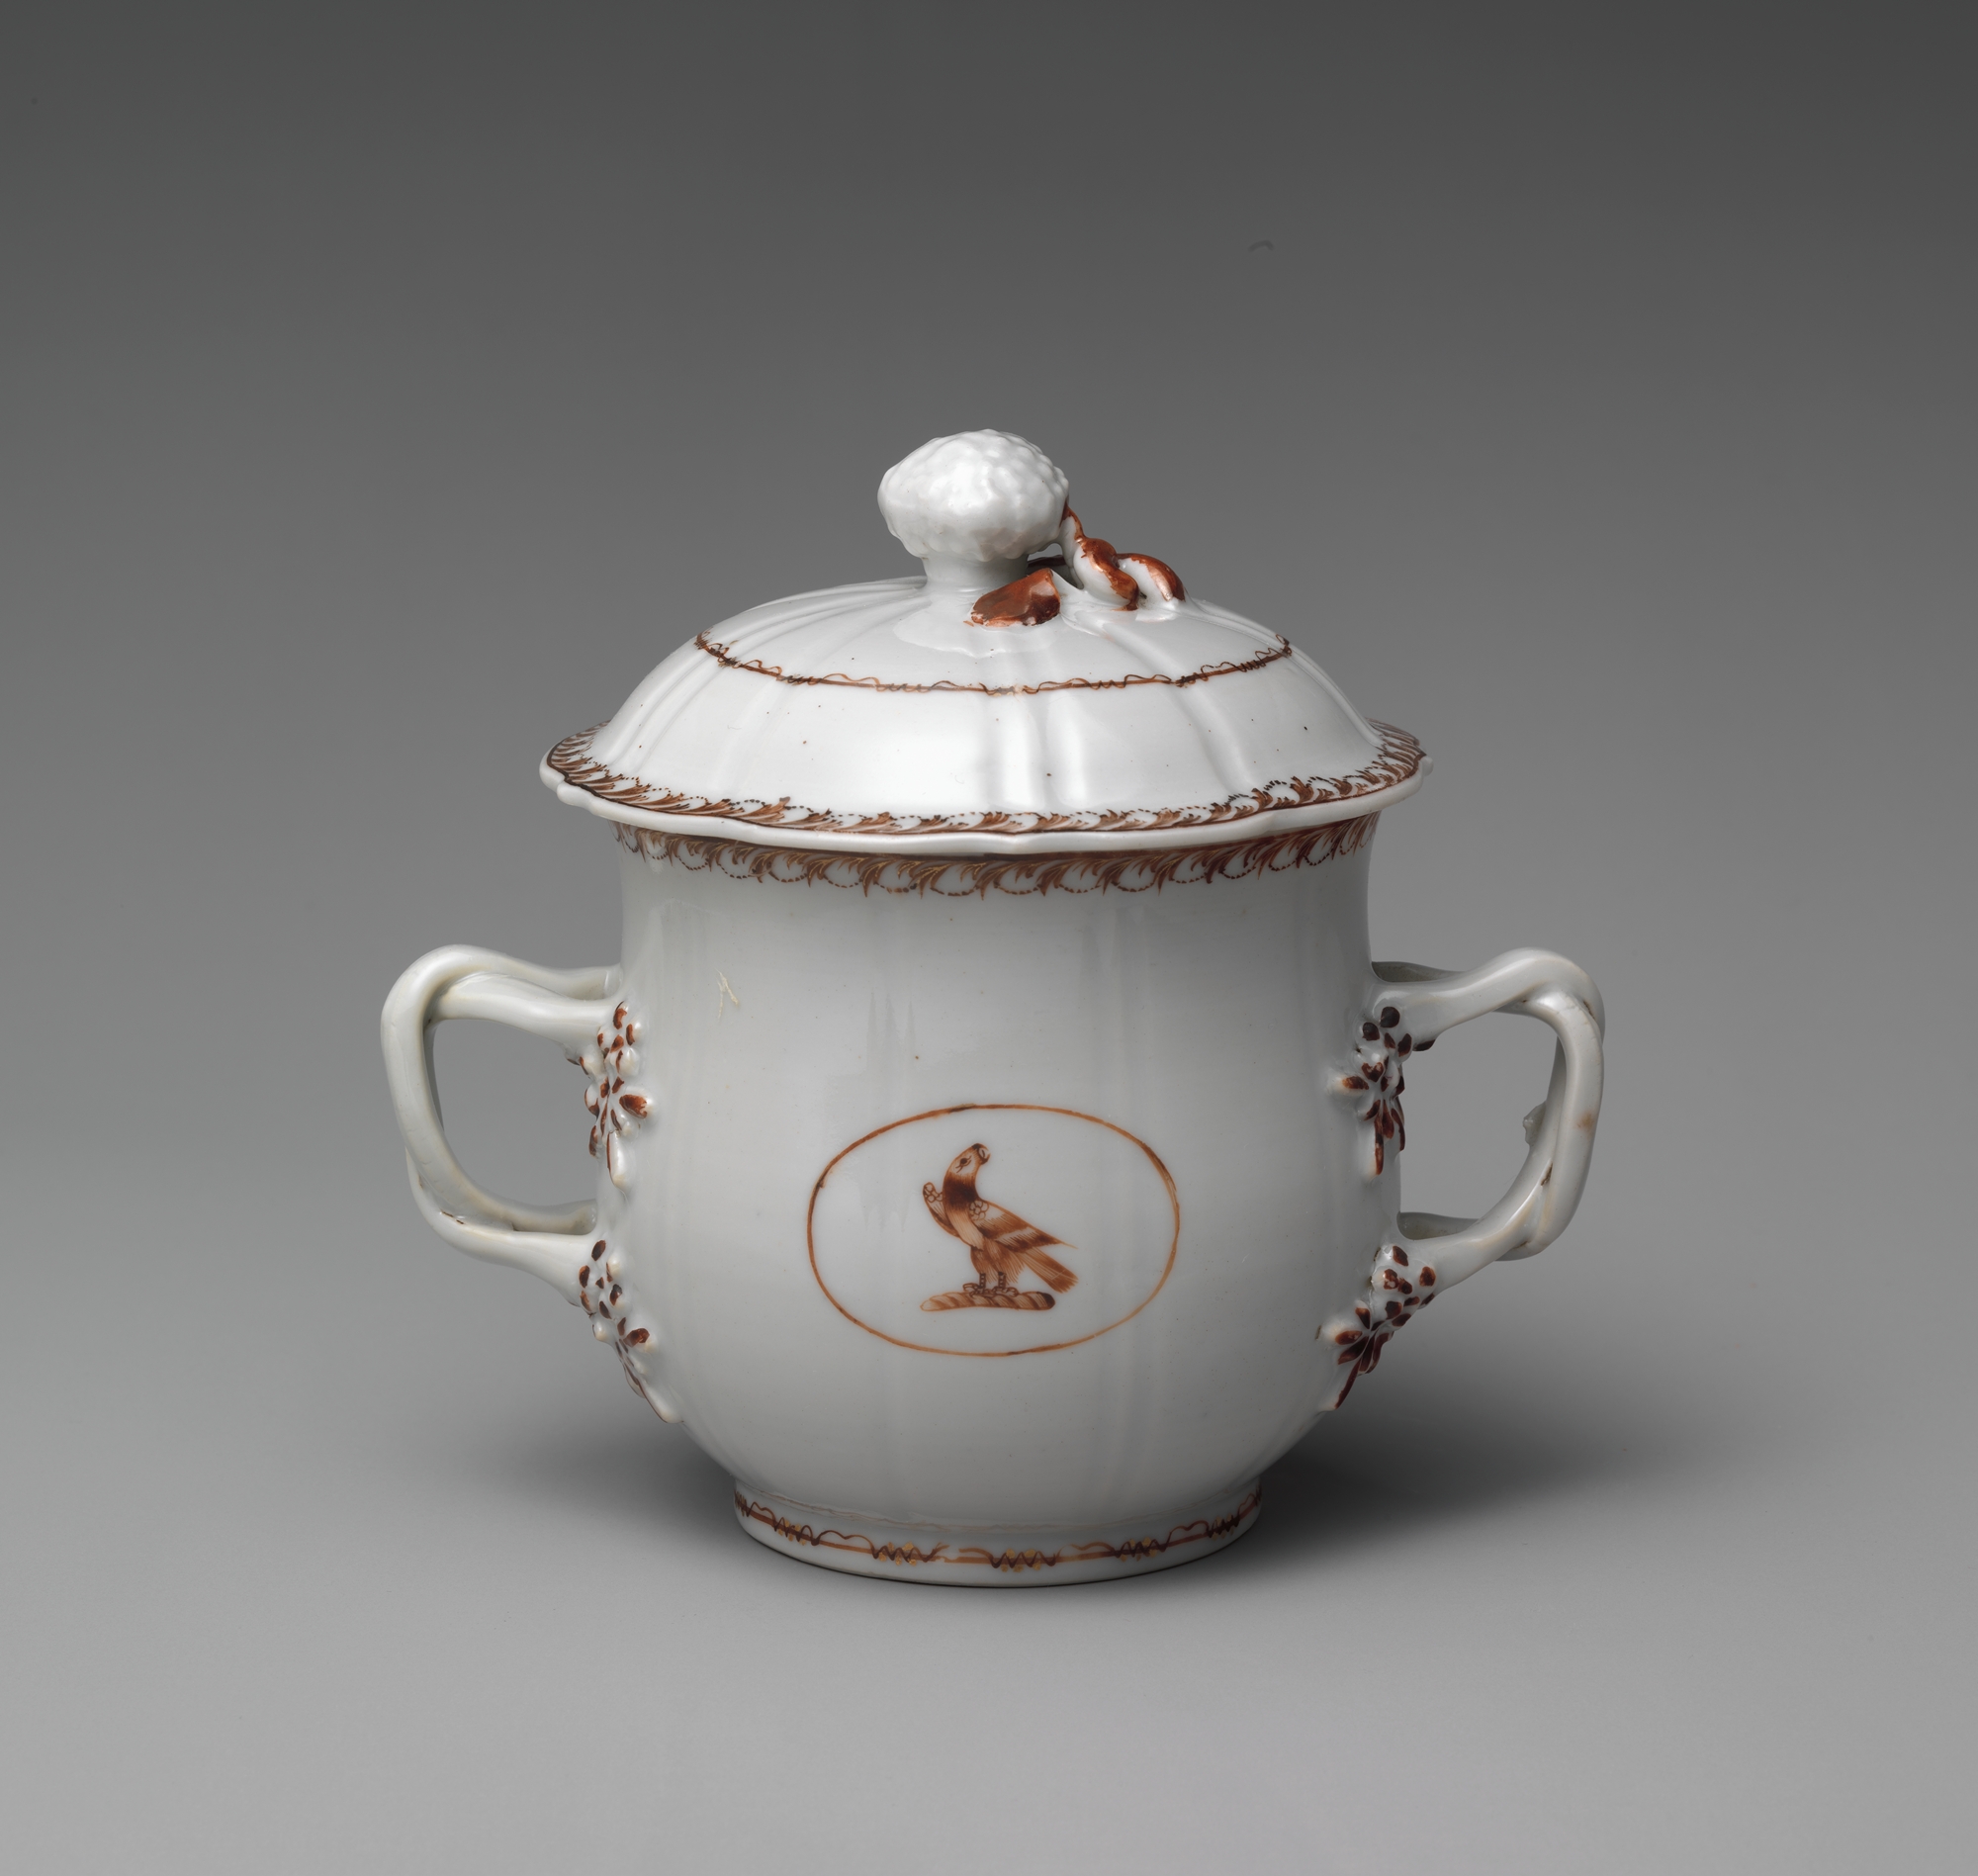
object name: sugar bowl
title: Covered Sugar Bowl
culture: chinese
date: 1770-1830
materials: porcelain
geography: china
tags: eagles